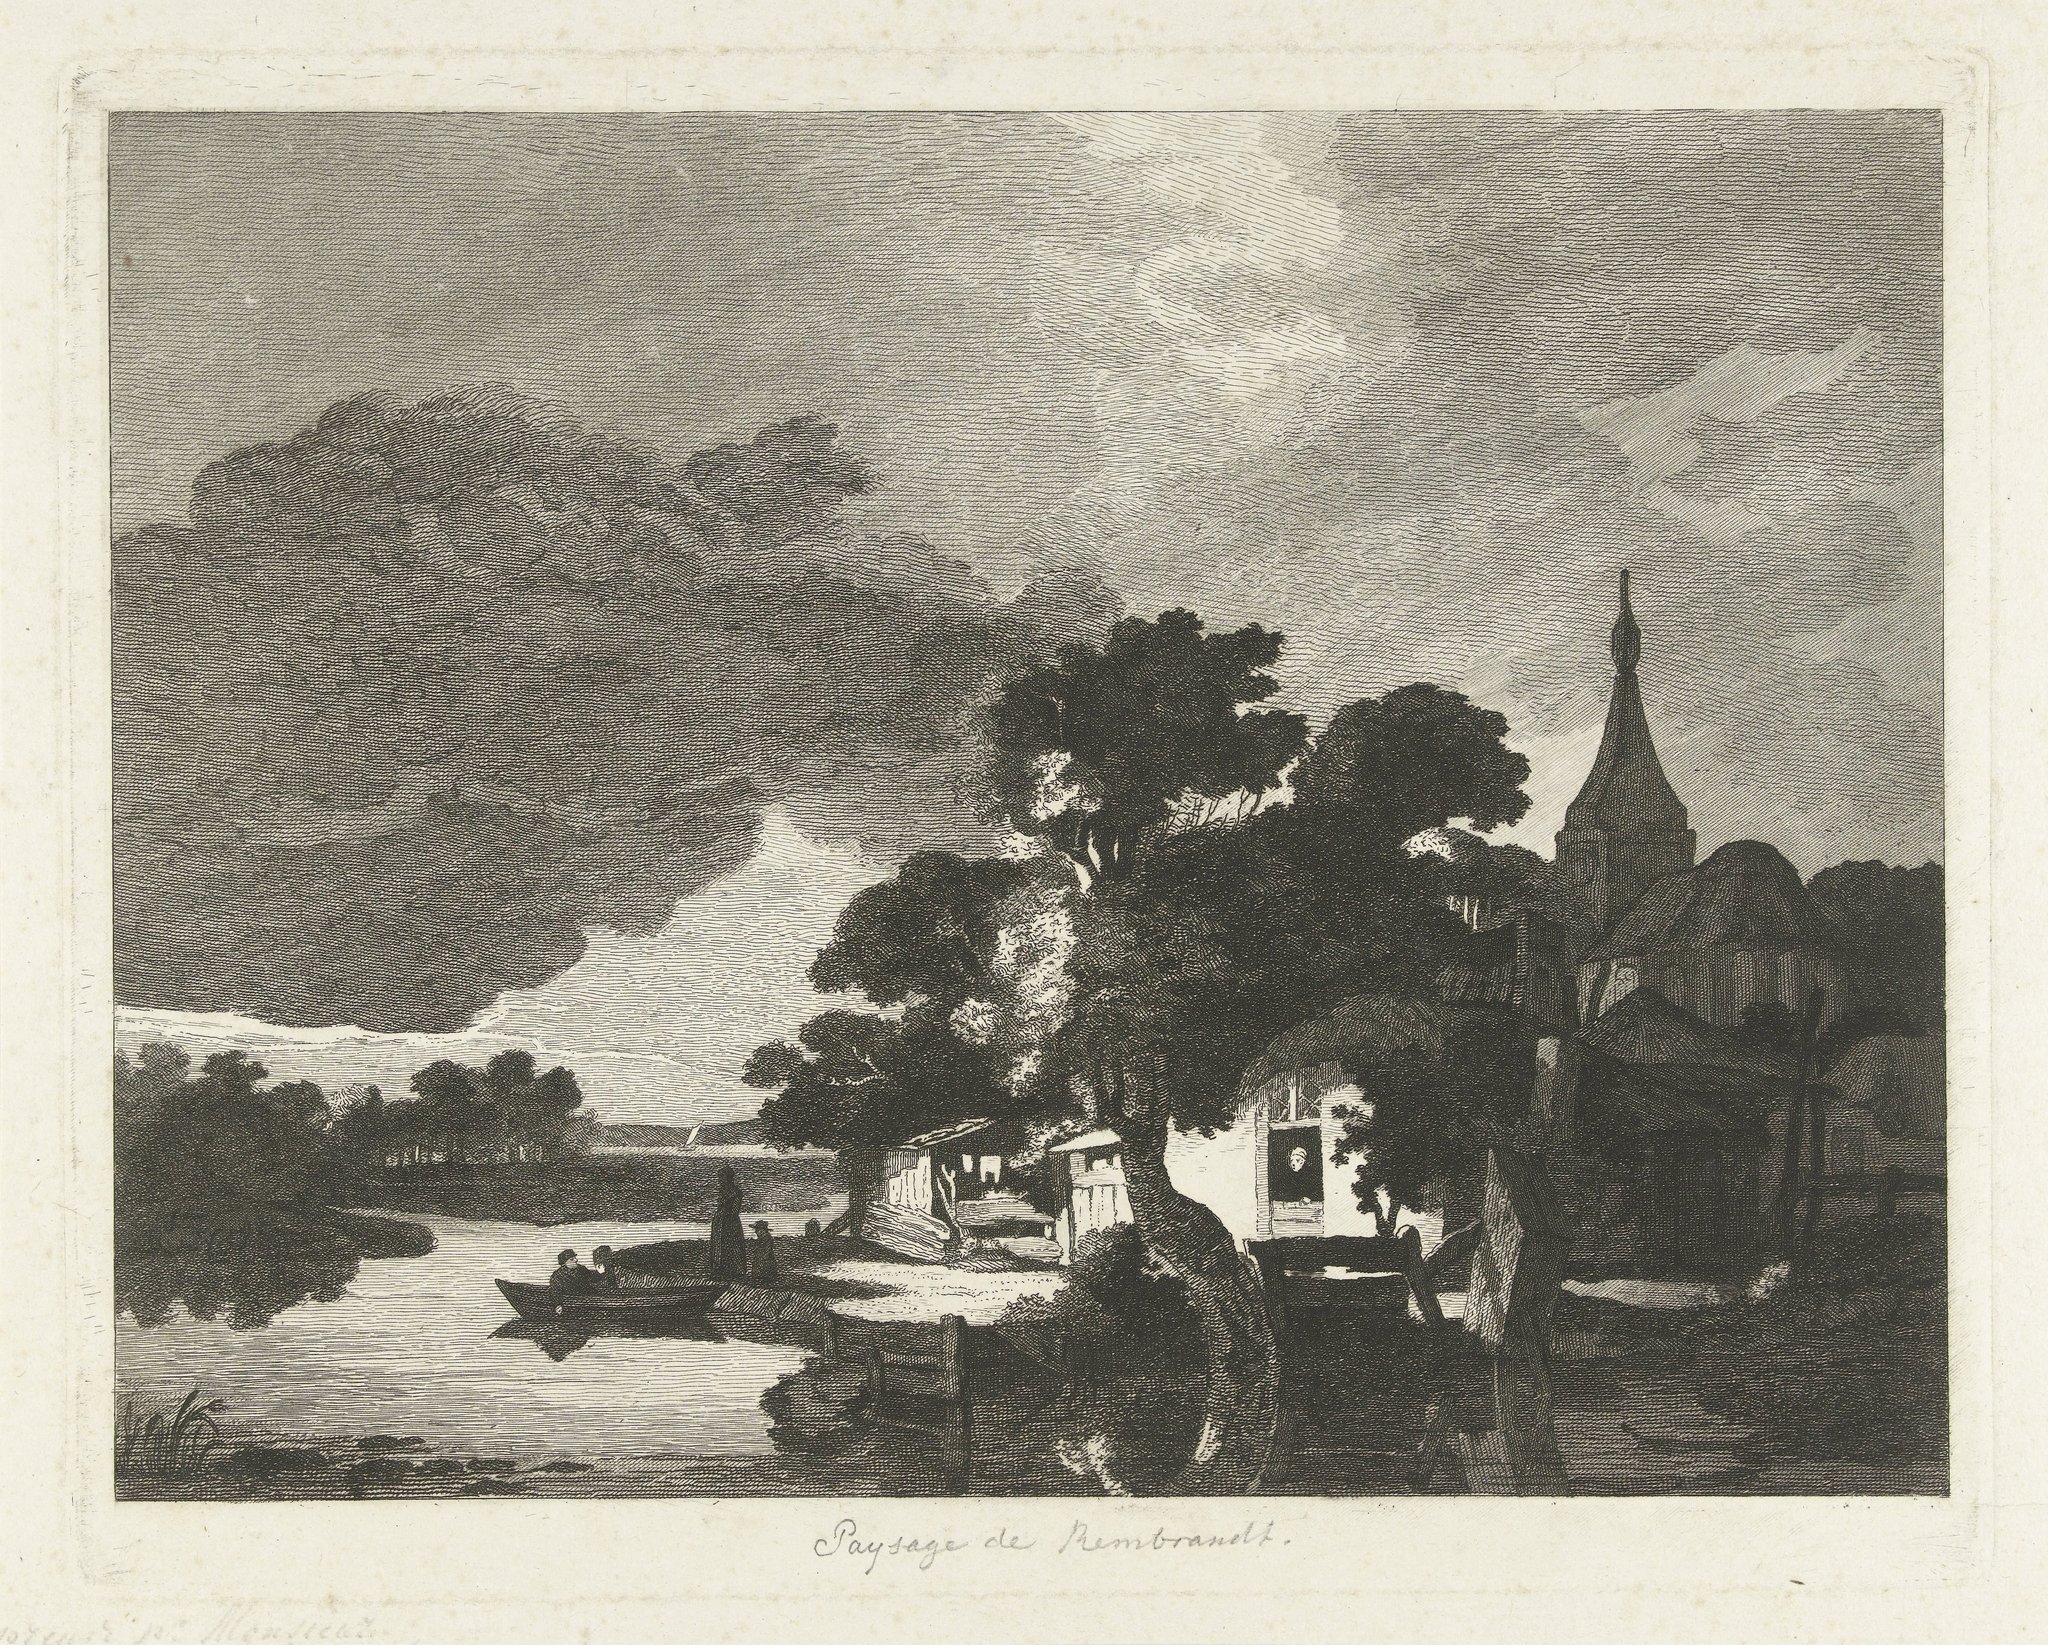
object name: print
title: Landschap met onweer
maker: lambertus antonius claessens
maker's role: draughtsman, print maker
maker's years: 1763-1834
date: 1792-1834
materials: paper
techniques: etching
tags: landscapes with waters, waterscapes, seascapes (in the temperate zone), thunderstorm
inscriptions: collector's mark: Lugt 2228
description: Landschap net een dorp bij een water. Aan de kade staat een vrouw met een kind een man zit in een roeibootje. Uit een verlicht huis kijkt een oude vrouw naar het groepje bij het water.